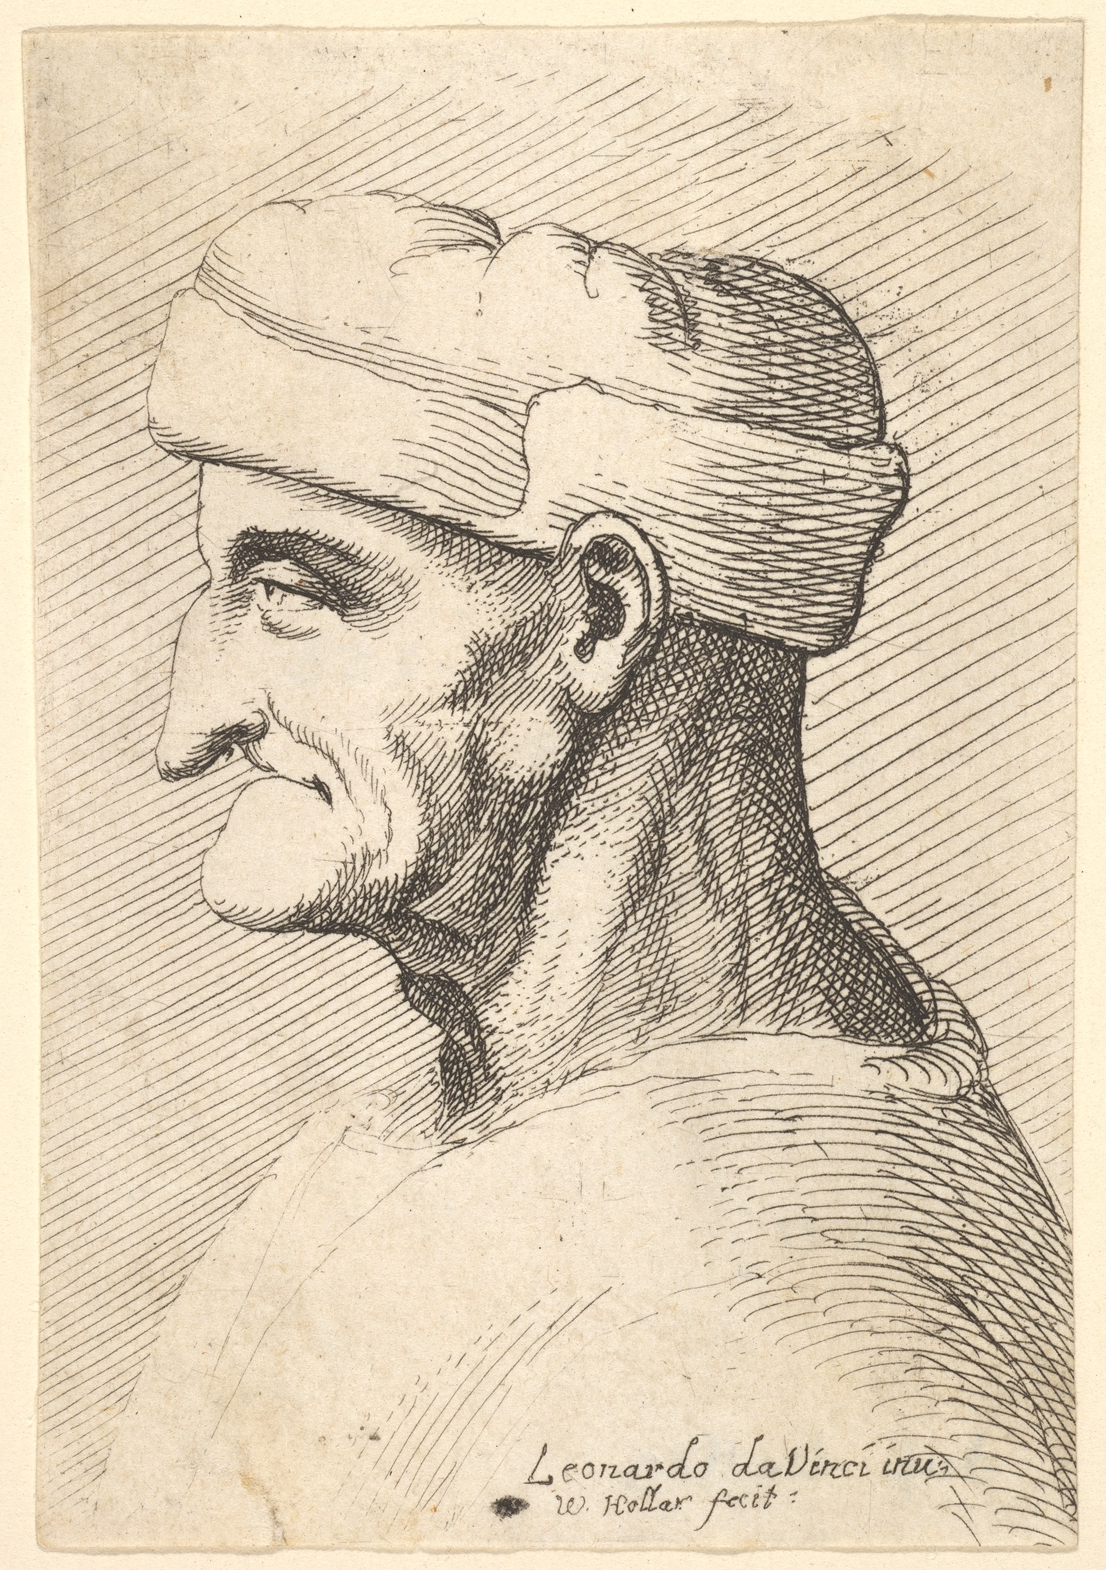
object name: print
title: Head of an old man wearing cap in profile to left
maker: wenceslaus hollar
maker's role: artist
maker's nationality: bohemian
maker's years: 1607-1677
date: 1644-1652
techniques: etching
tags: men